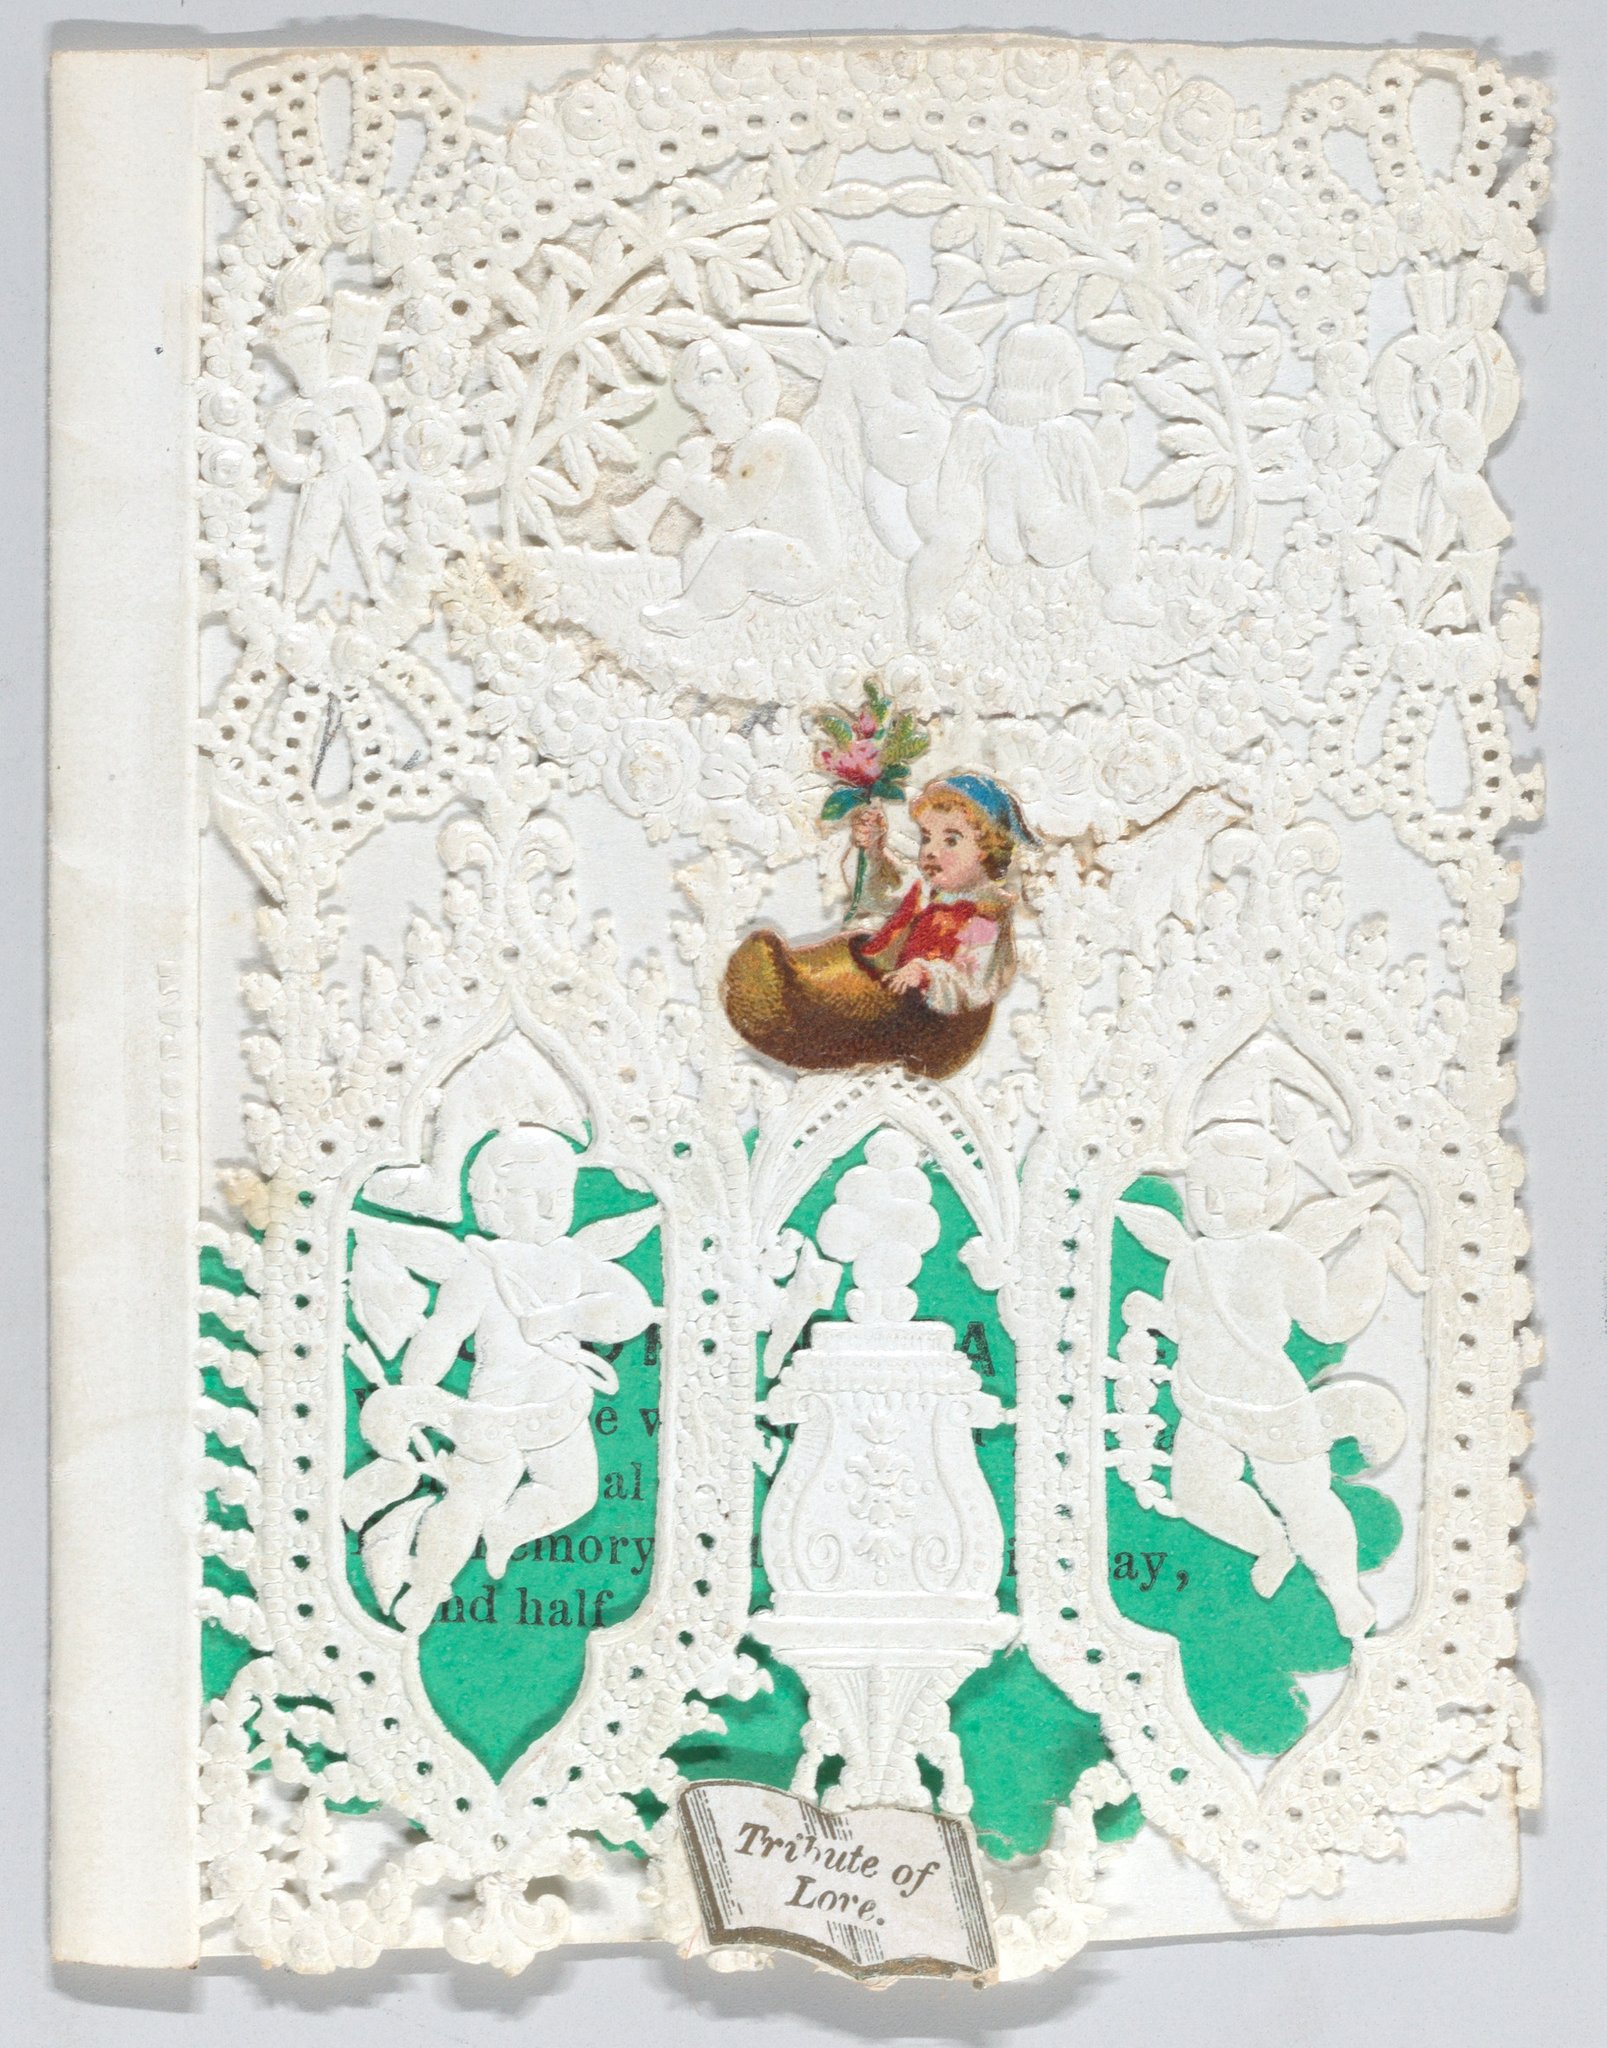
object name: valentine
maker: Anonymous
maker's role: artist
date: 1847-1870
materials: graphite, lace, paper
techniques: chromolithography, embossing, open work